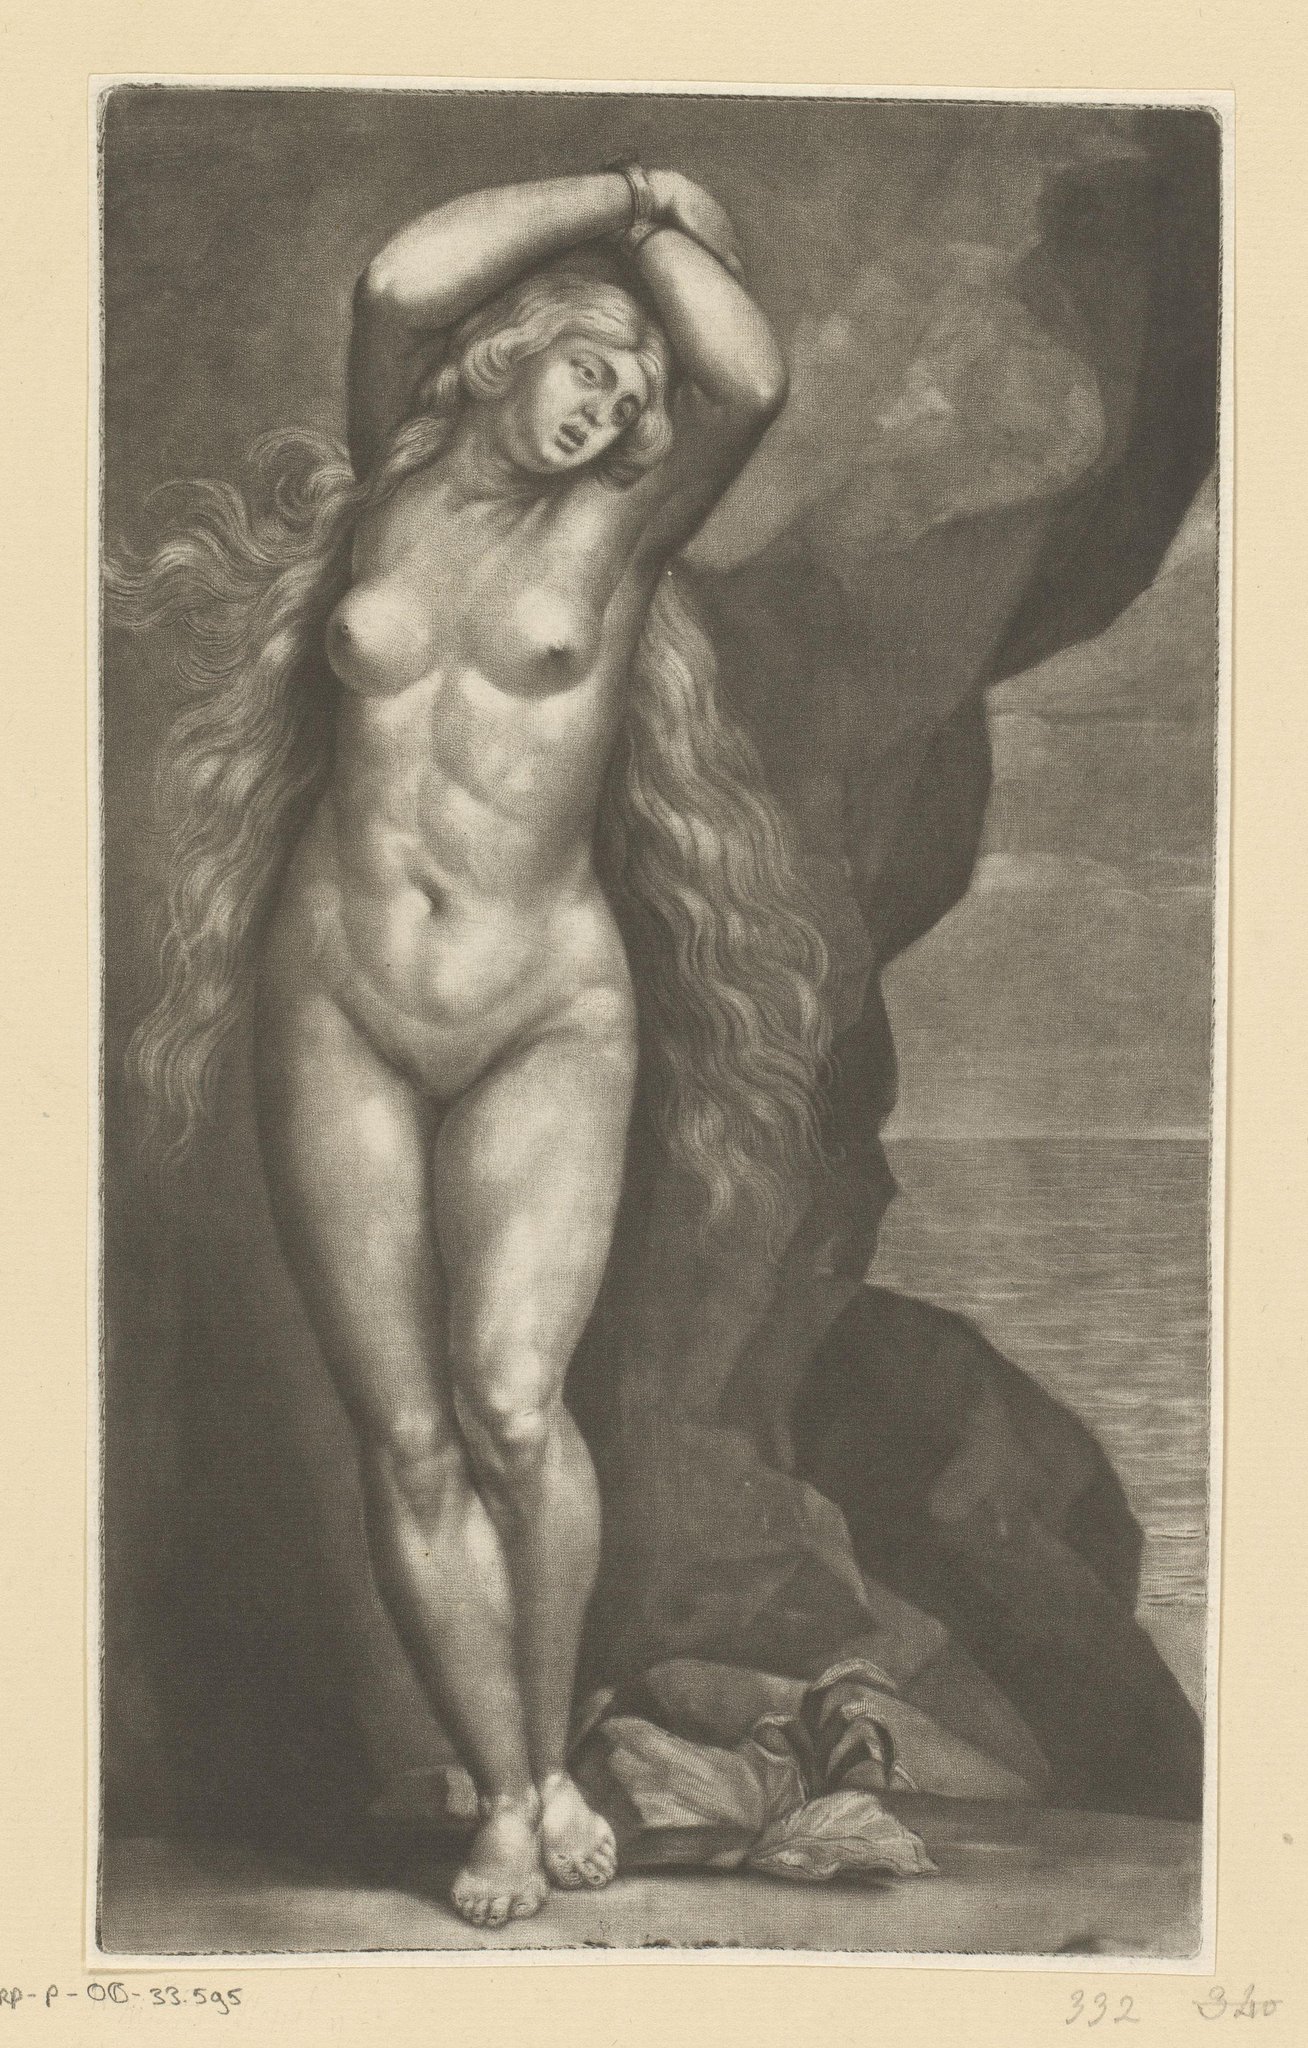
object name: print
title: Andromeda aan de rots geketend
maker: Anonymous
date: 1680-1720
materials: paper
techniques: mezzotint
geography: england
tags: andromeda chained to the rock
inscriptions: collector's mark: Lugt 240